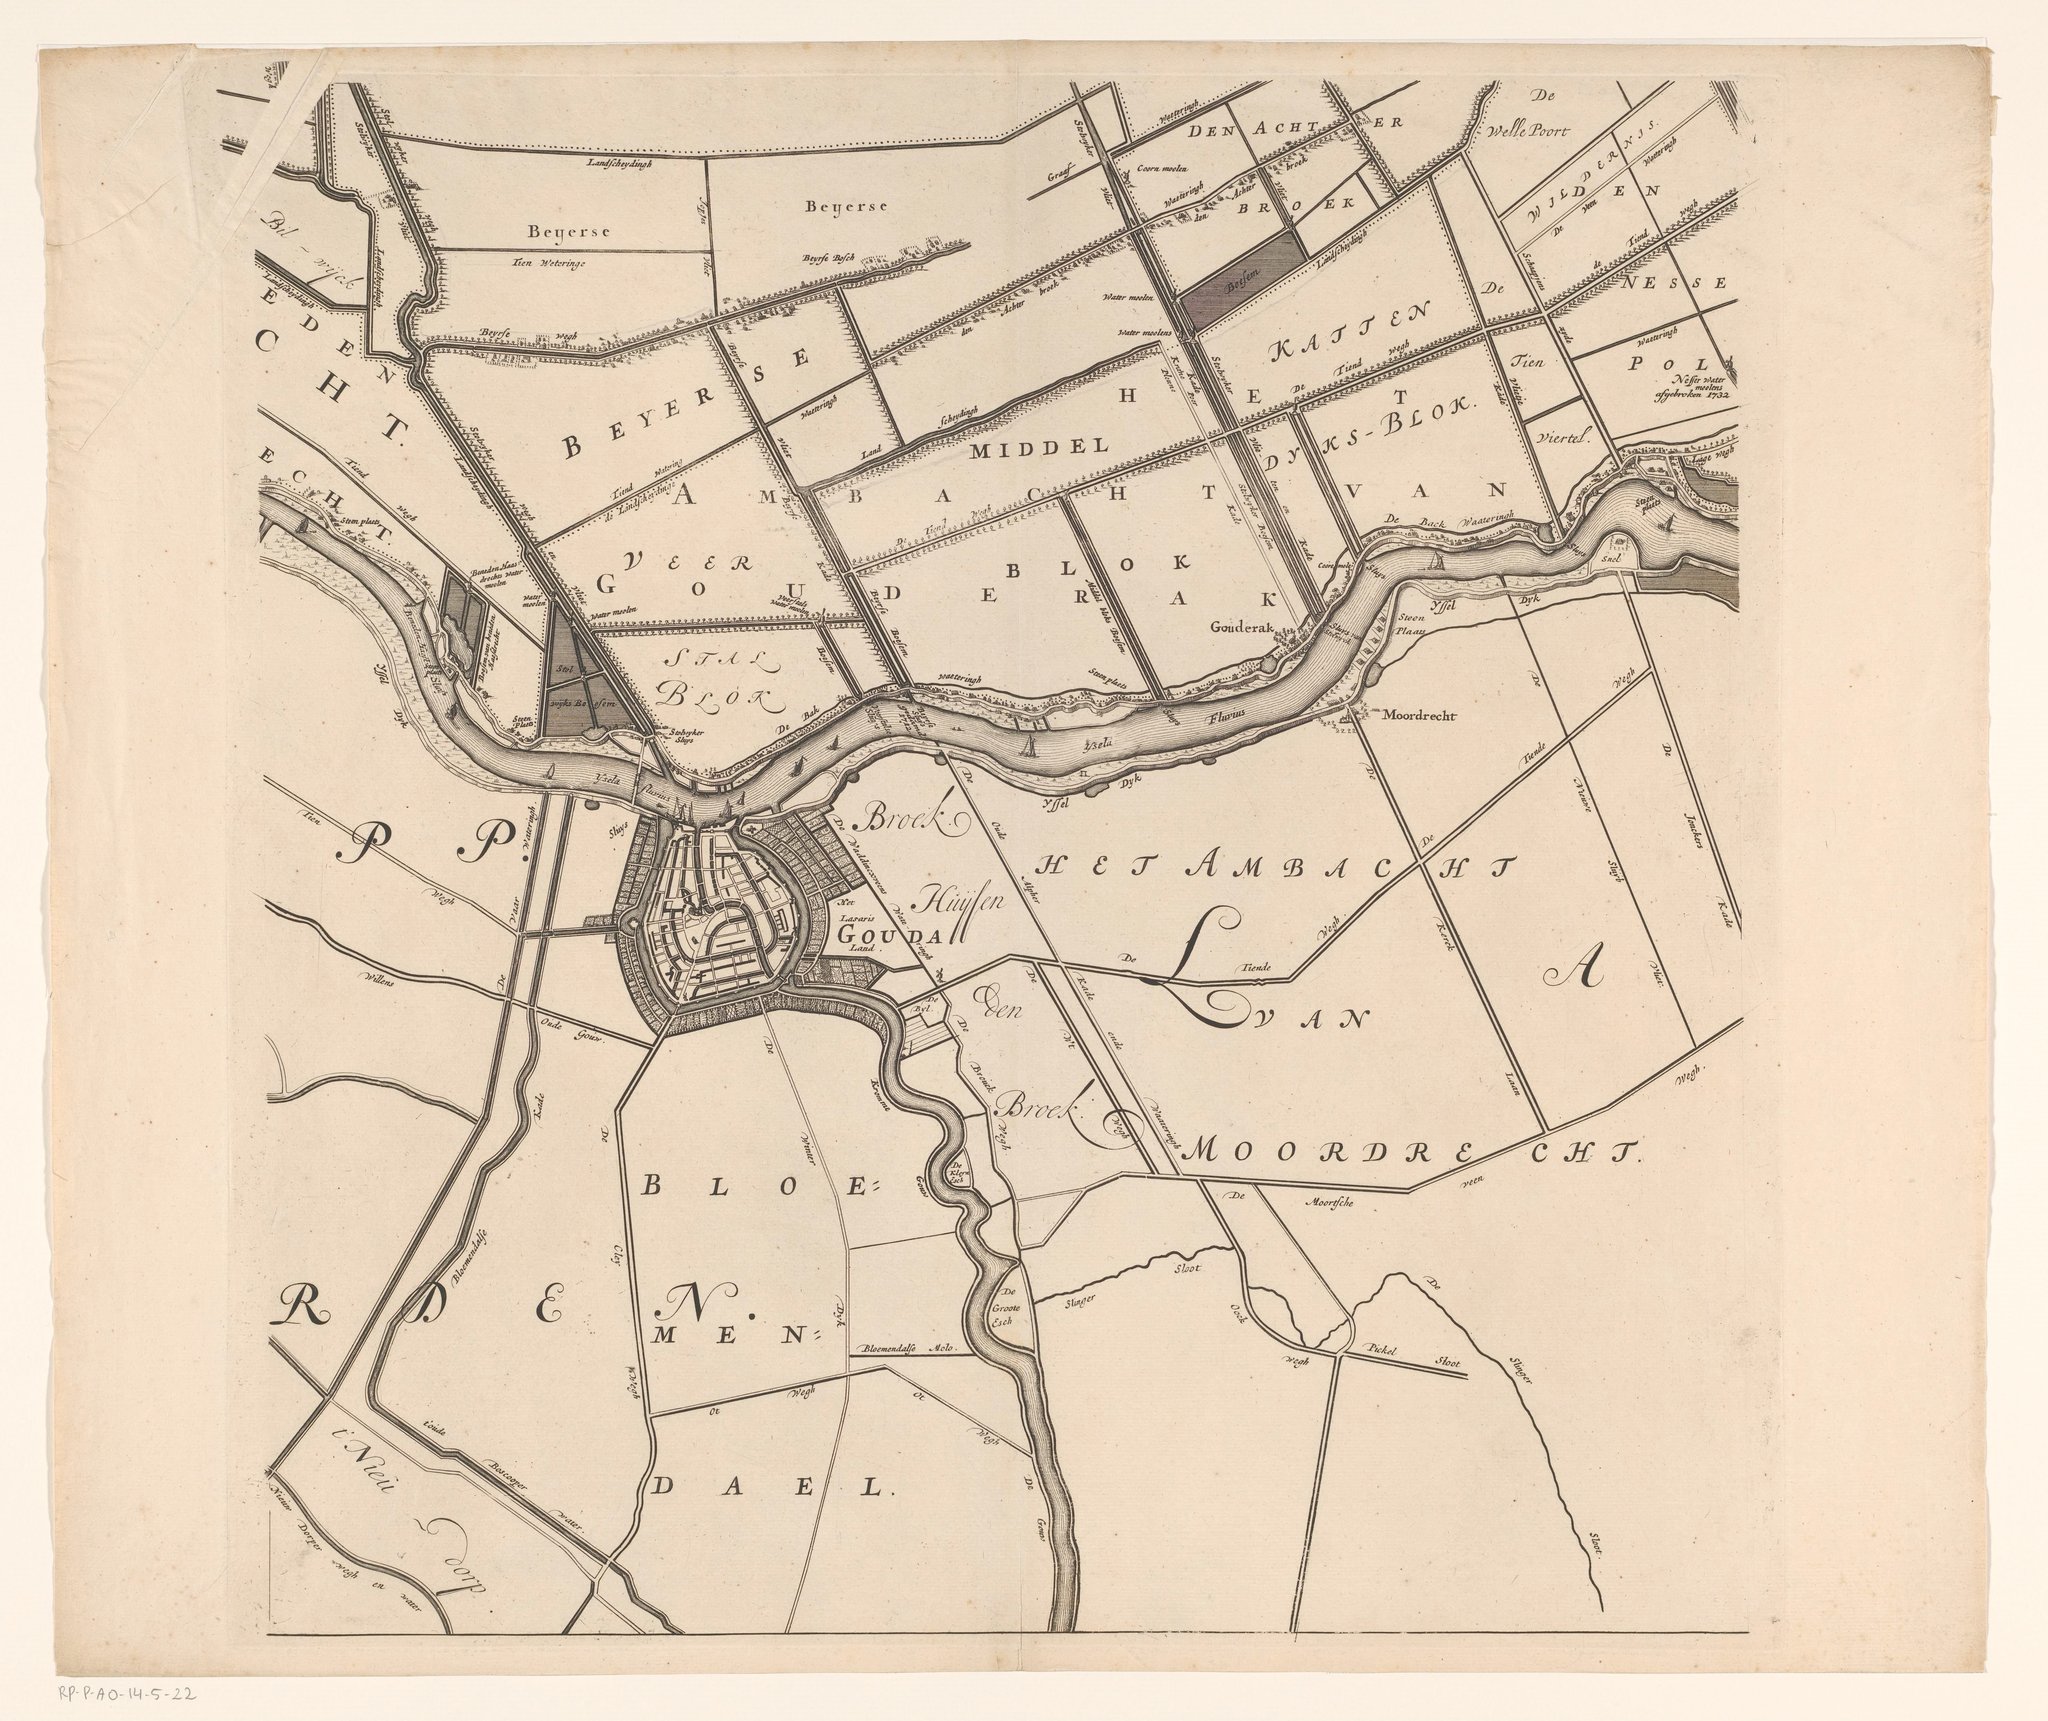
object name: map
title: Het Hooge Heemraadschap van de Crimpenre Waard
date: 1683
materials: paper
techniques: engraving, etching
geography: amsterdam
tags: maps of separate countries or regions, maps of cities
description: Vijfde deel van de kaart van de vijfde druk van 'Het Hooge Heemraadschap van de Crimpenre Waard', een wandkaart (bestaande uit een zesdelige kaart en een wapenrand) van het Hoogheemraadschap van de Krimpenerwaard.